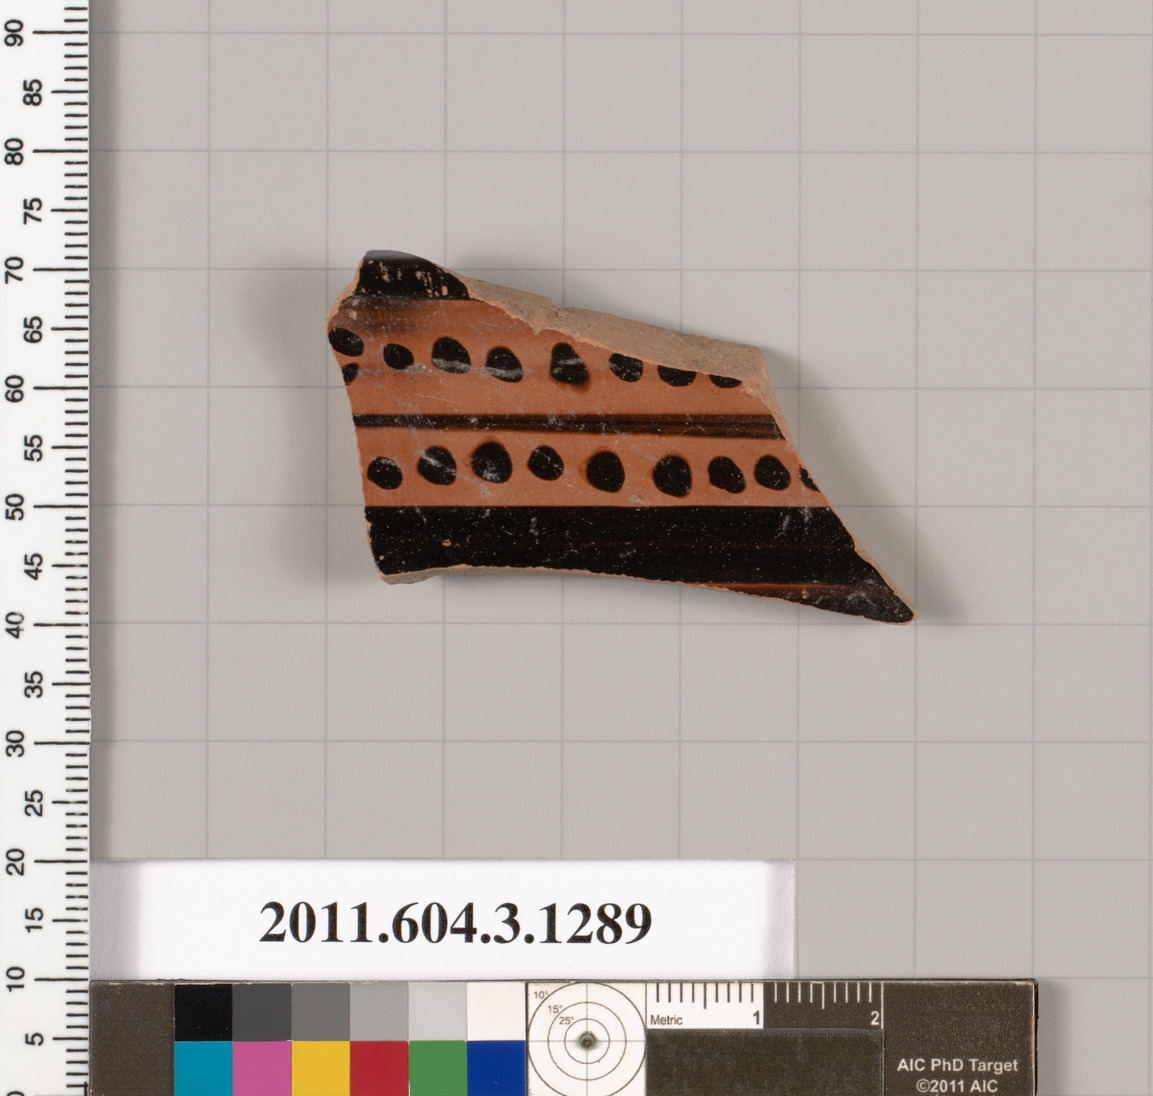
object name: skyphos fragment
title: Terracotta rim fragment of a skyphos (deep drinking cup)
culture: greek, attic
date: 500 BCE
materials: terracotta